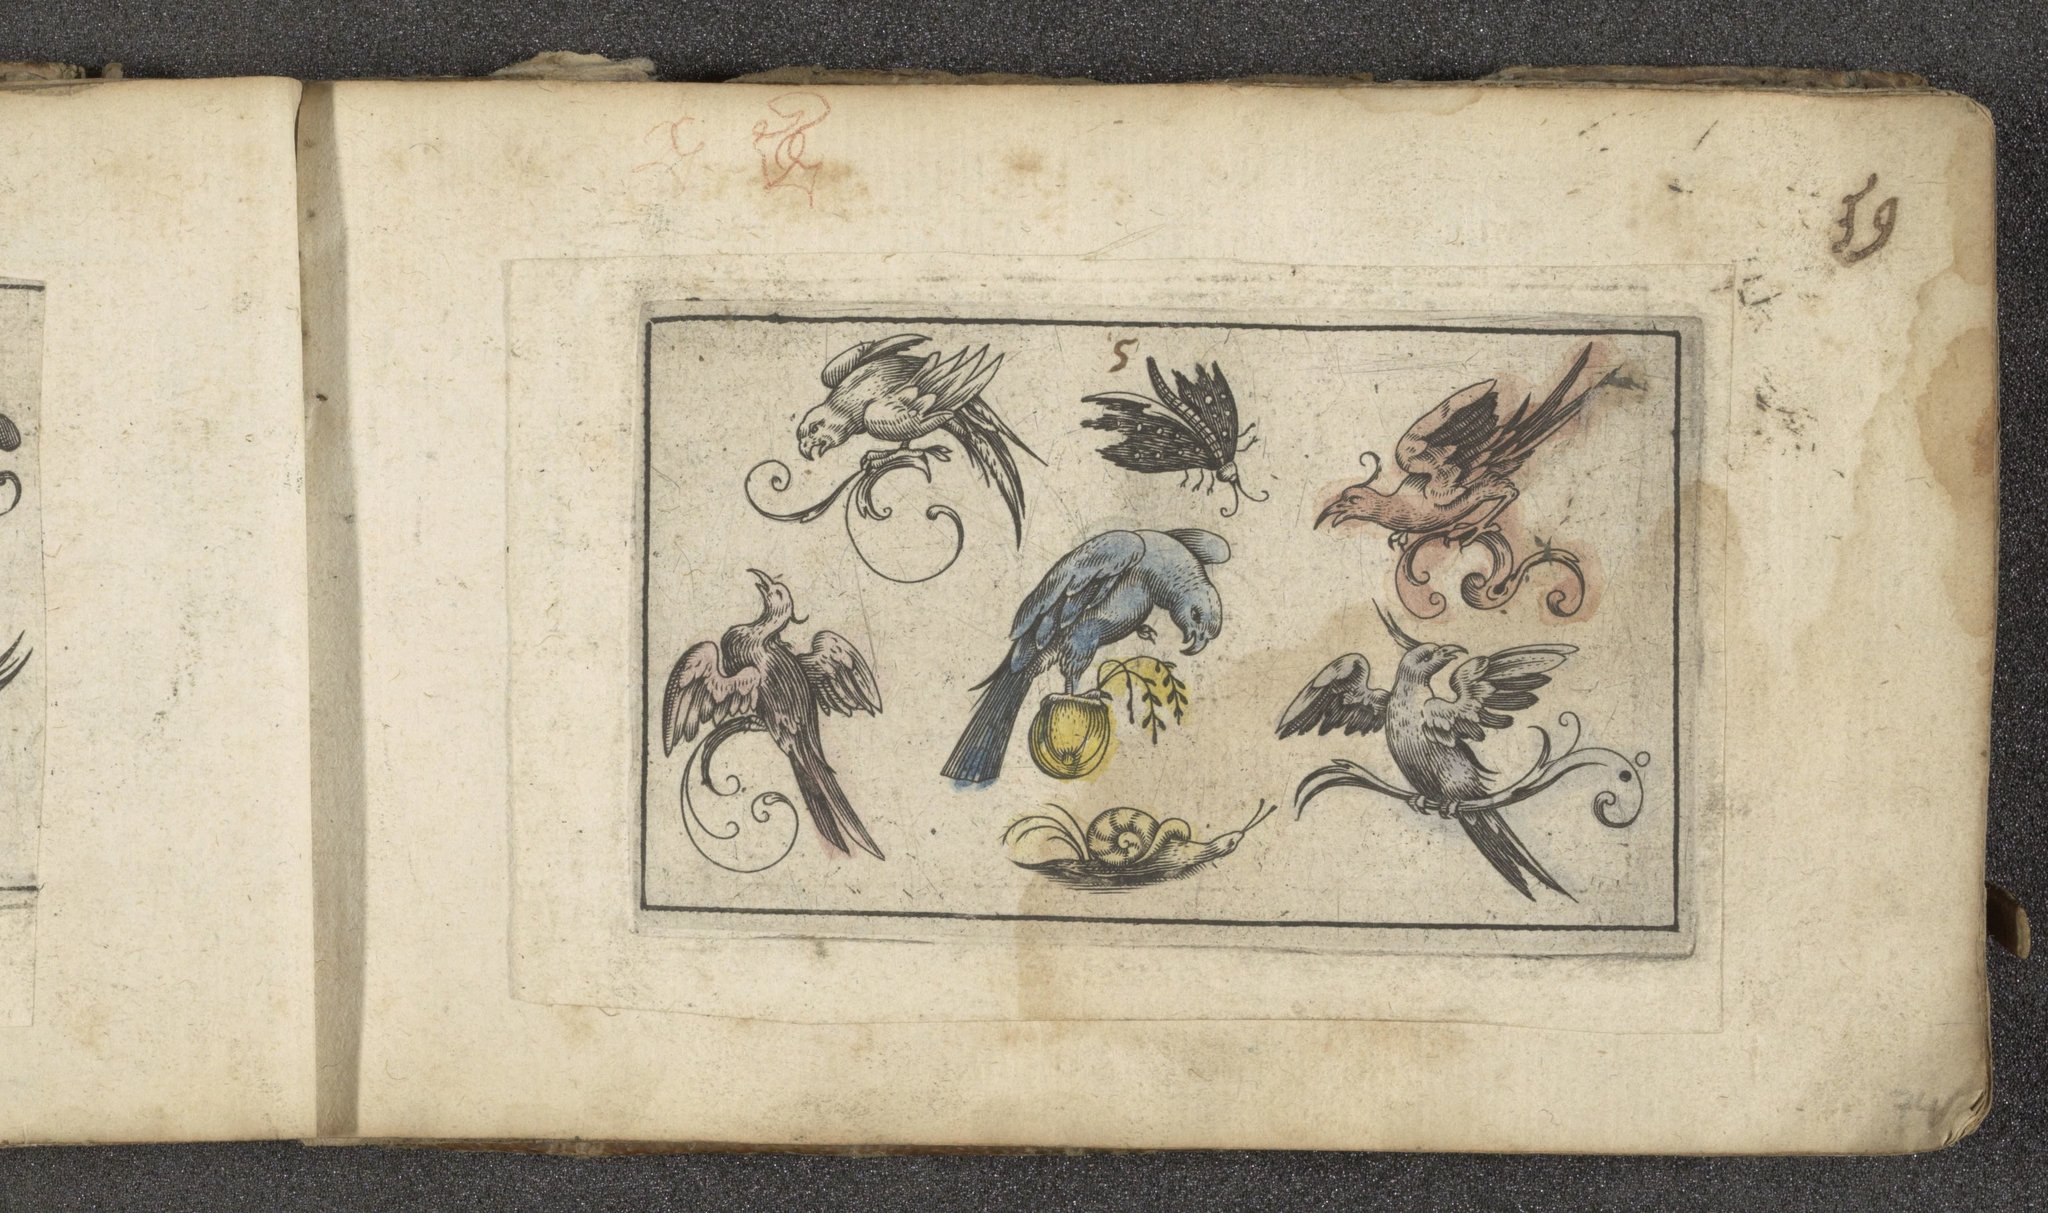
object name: ornament print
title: Vijf vogels, een vlinder en een slak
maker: Anonymous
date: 1601-1650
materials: paper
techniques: colour, engraving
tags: birds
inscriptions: inscription: ‘59’, inscription: ‘5’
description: Vijf vogels, een vlinder en een slak. De prent maakt deel uit van een album.